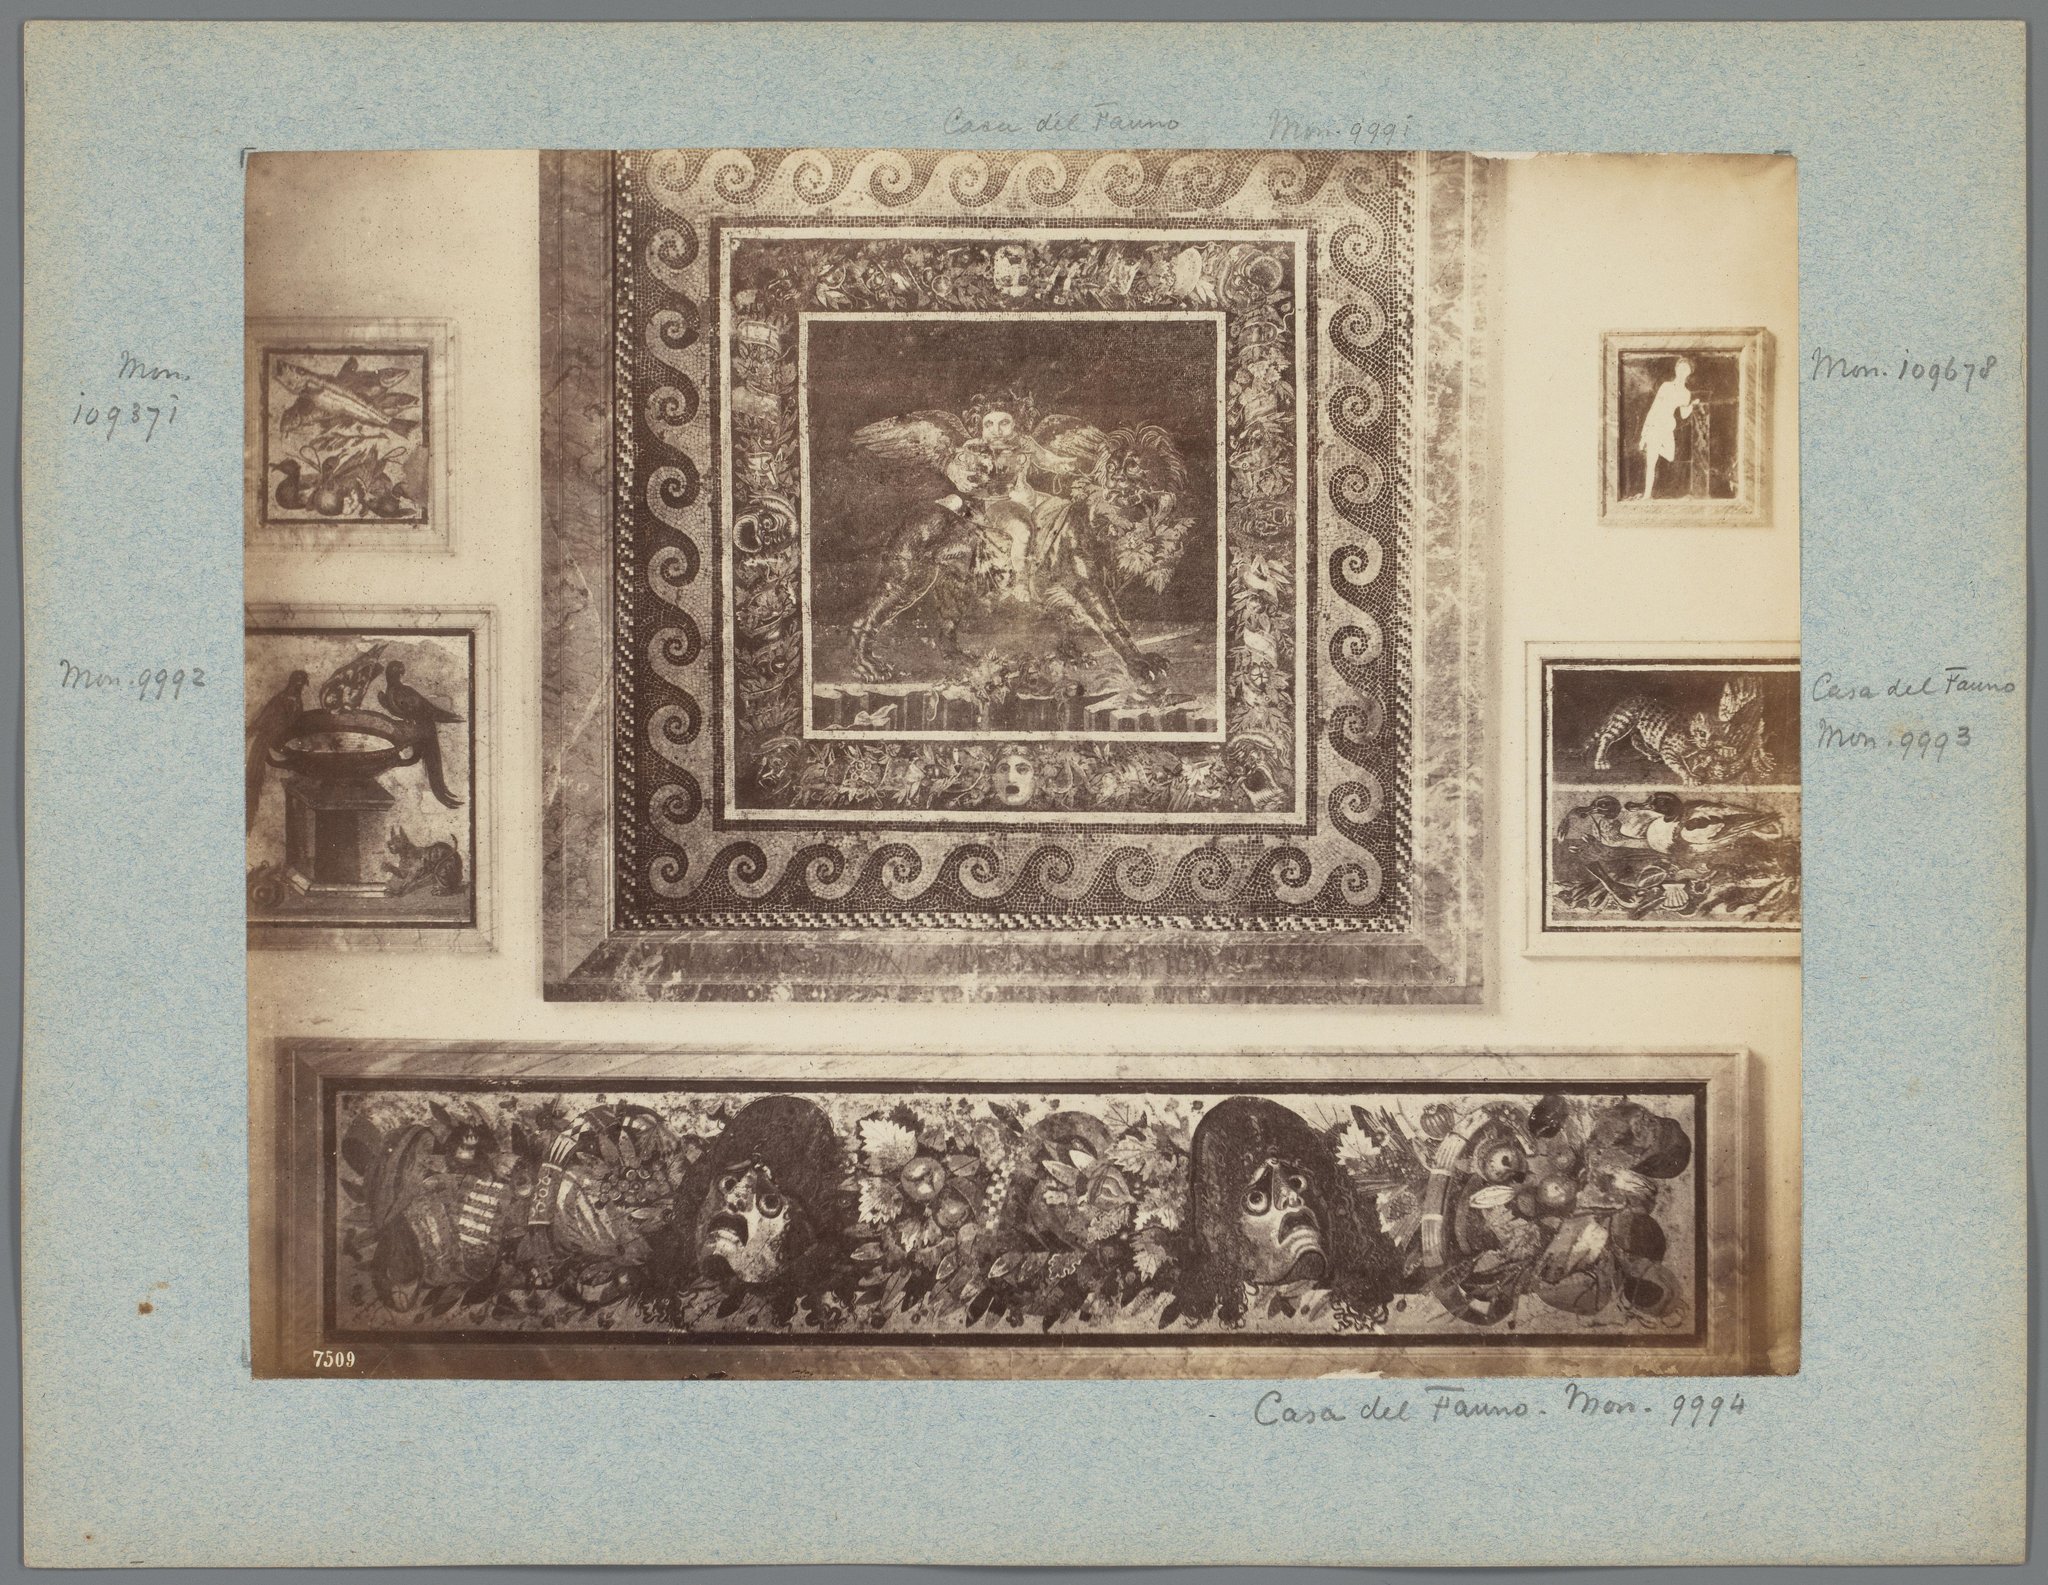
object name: photograph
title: Zes mozaïeken uit het Huis van de Faun in Pompeï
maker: Anonymous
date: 1860-1890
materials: cardboard, paper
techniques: albumen print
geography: pompeii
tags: mask, animals, beasts of prey, predatory animals: lion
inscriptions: number: ‘7509’, inscription: ‘Casa del Fauno Mon. 9991/ Mon. 109678/ Casa del Fauno/ Mon. 9993/ Casa del Fauno. Mon. 9994/ Mon. 9992/ Mon./ 109371’